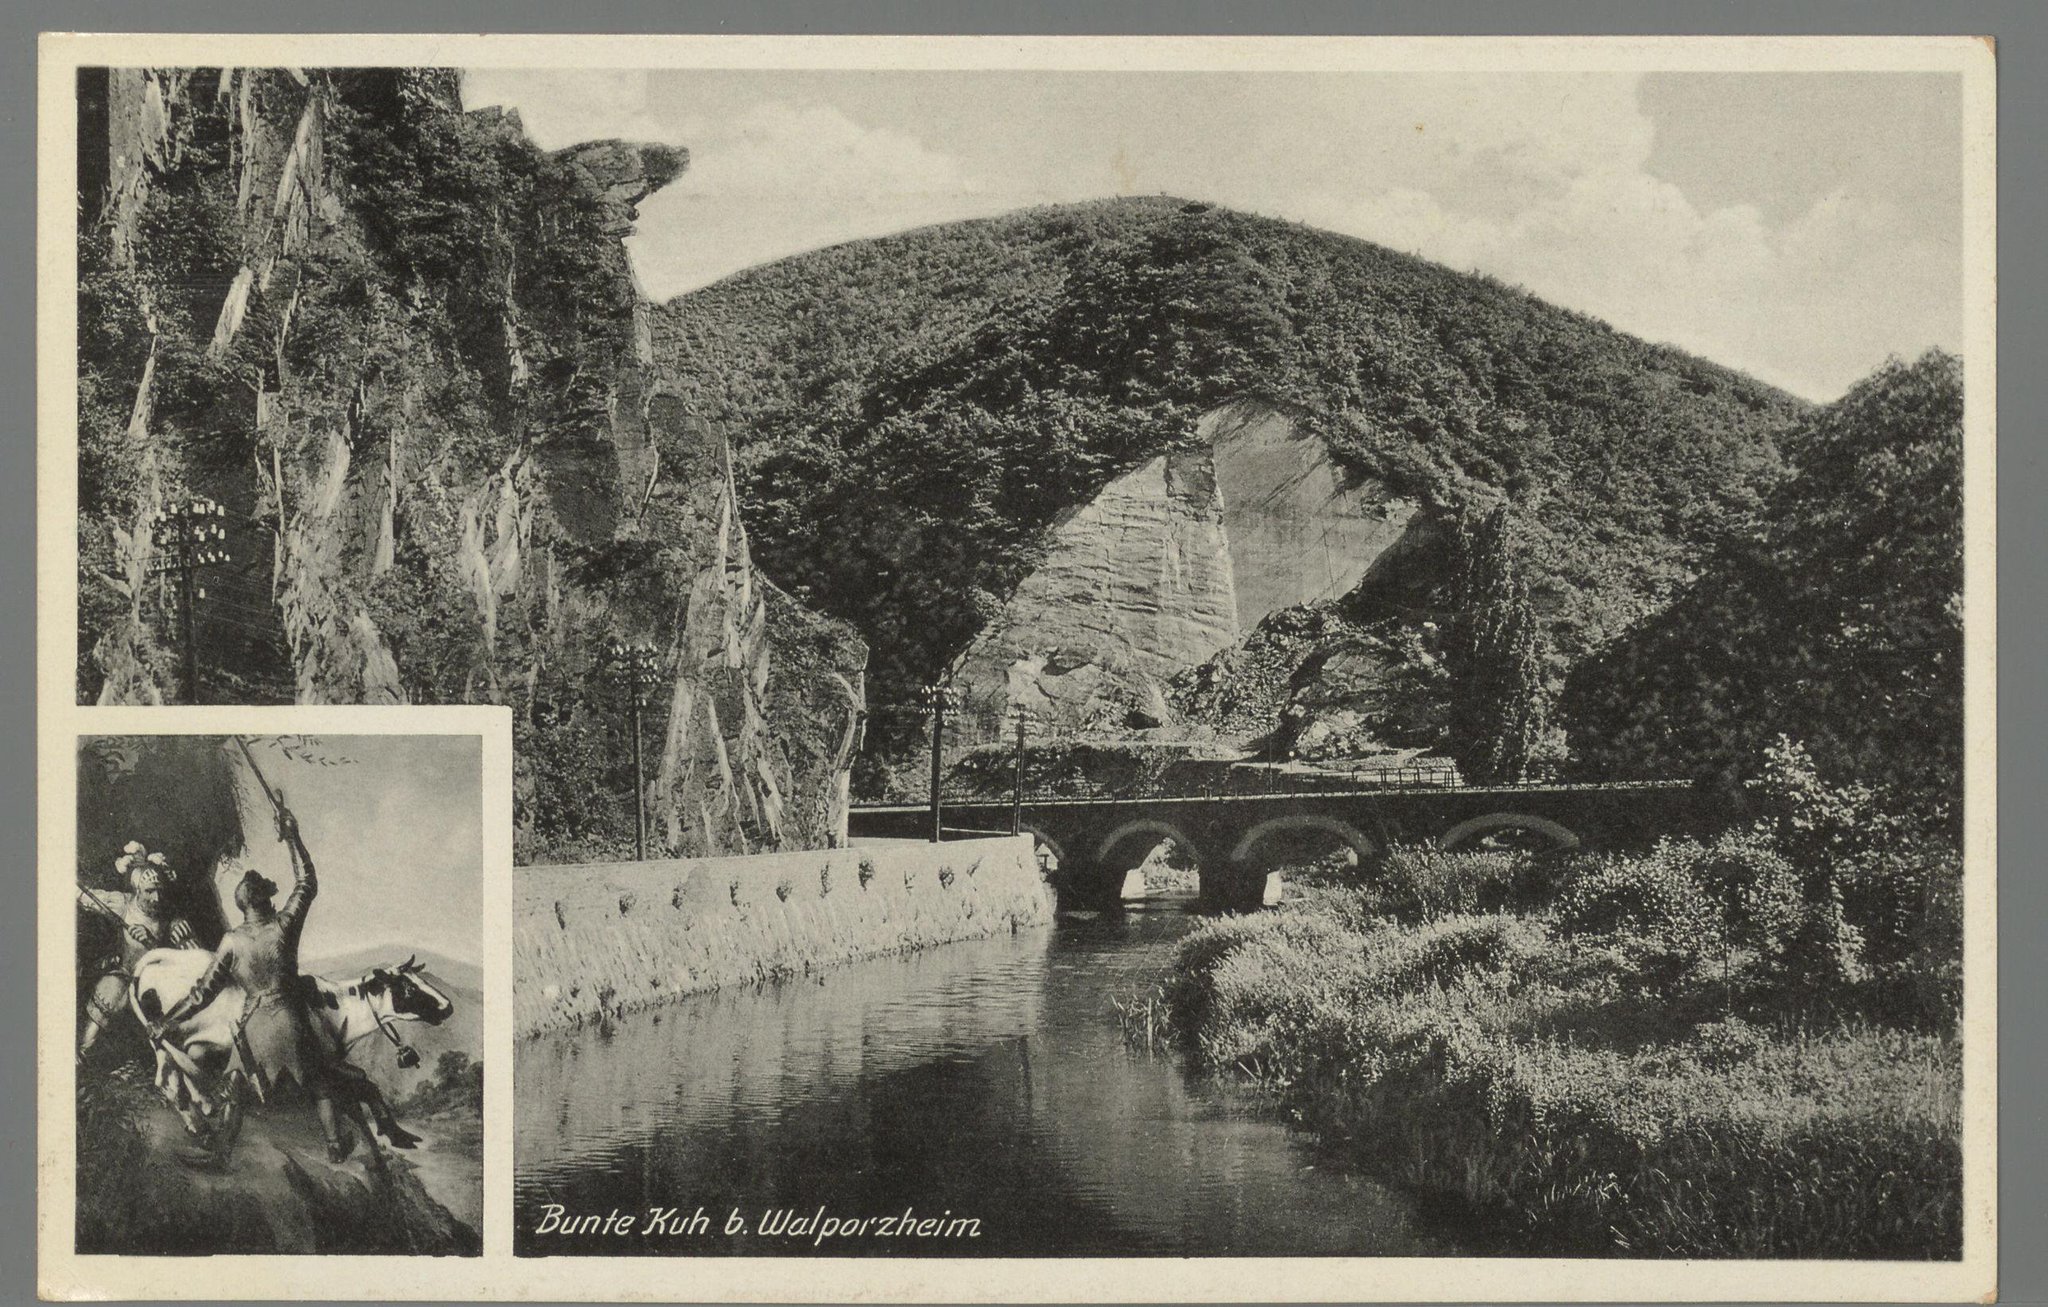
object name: ansichtkaart, prentbriefkaart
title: Bunte Kuh b. Walporzheim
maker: Anonymous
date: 1905-1930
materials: cardboard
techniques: photograph, writing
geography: walporzheim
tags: river, bridge, mountains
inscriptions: postage stamp